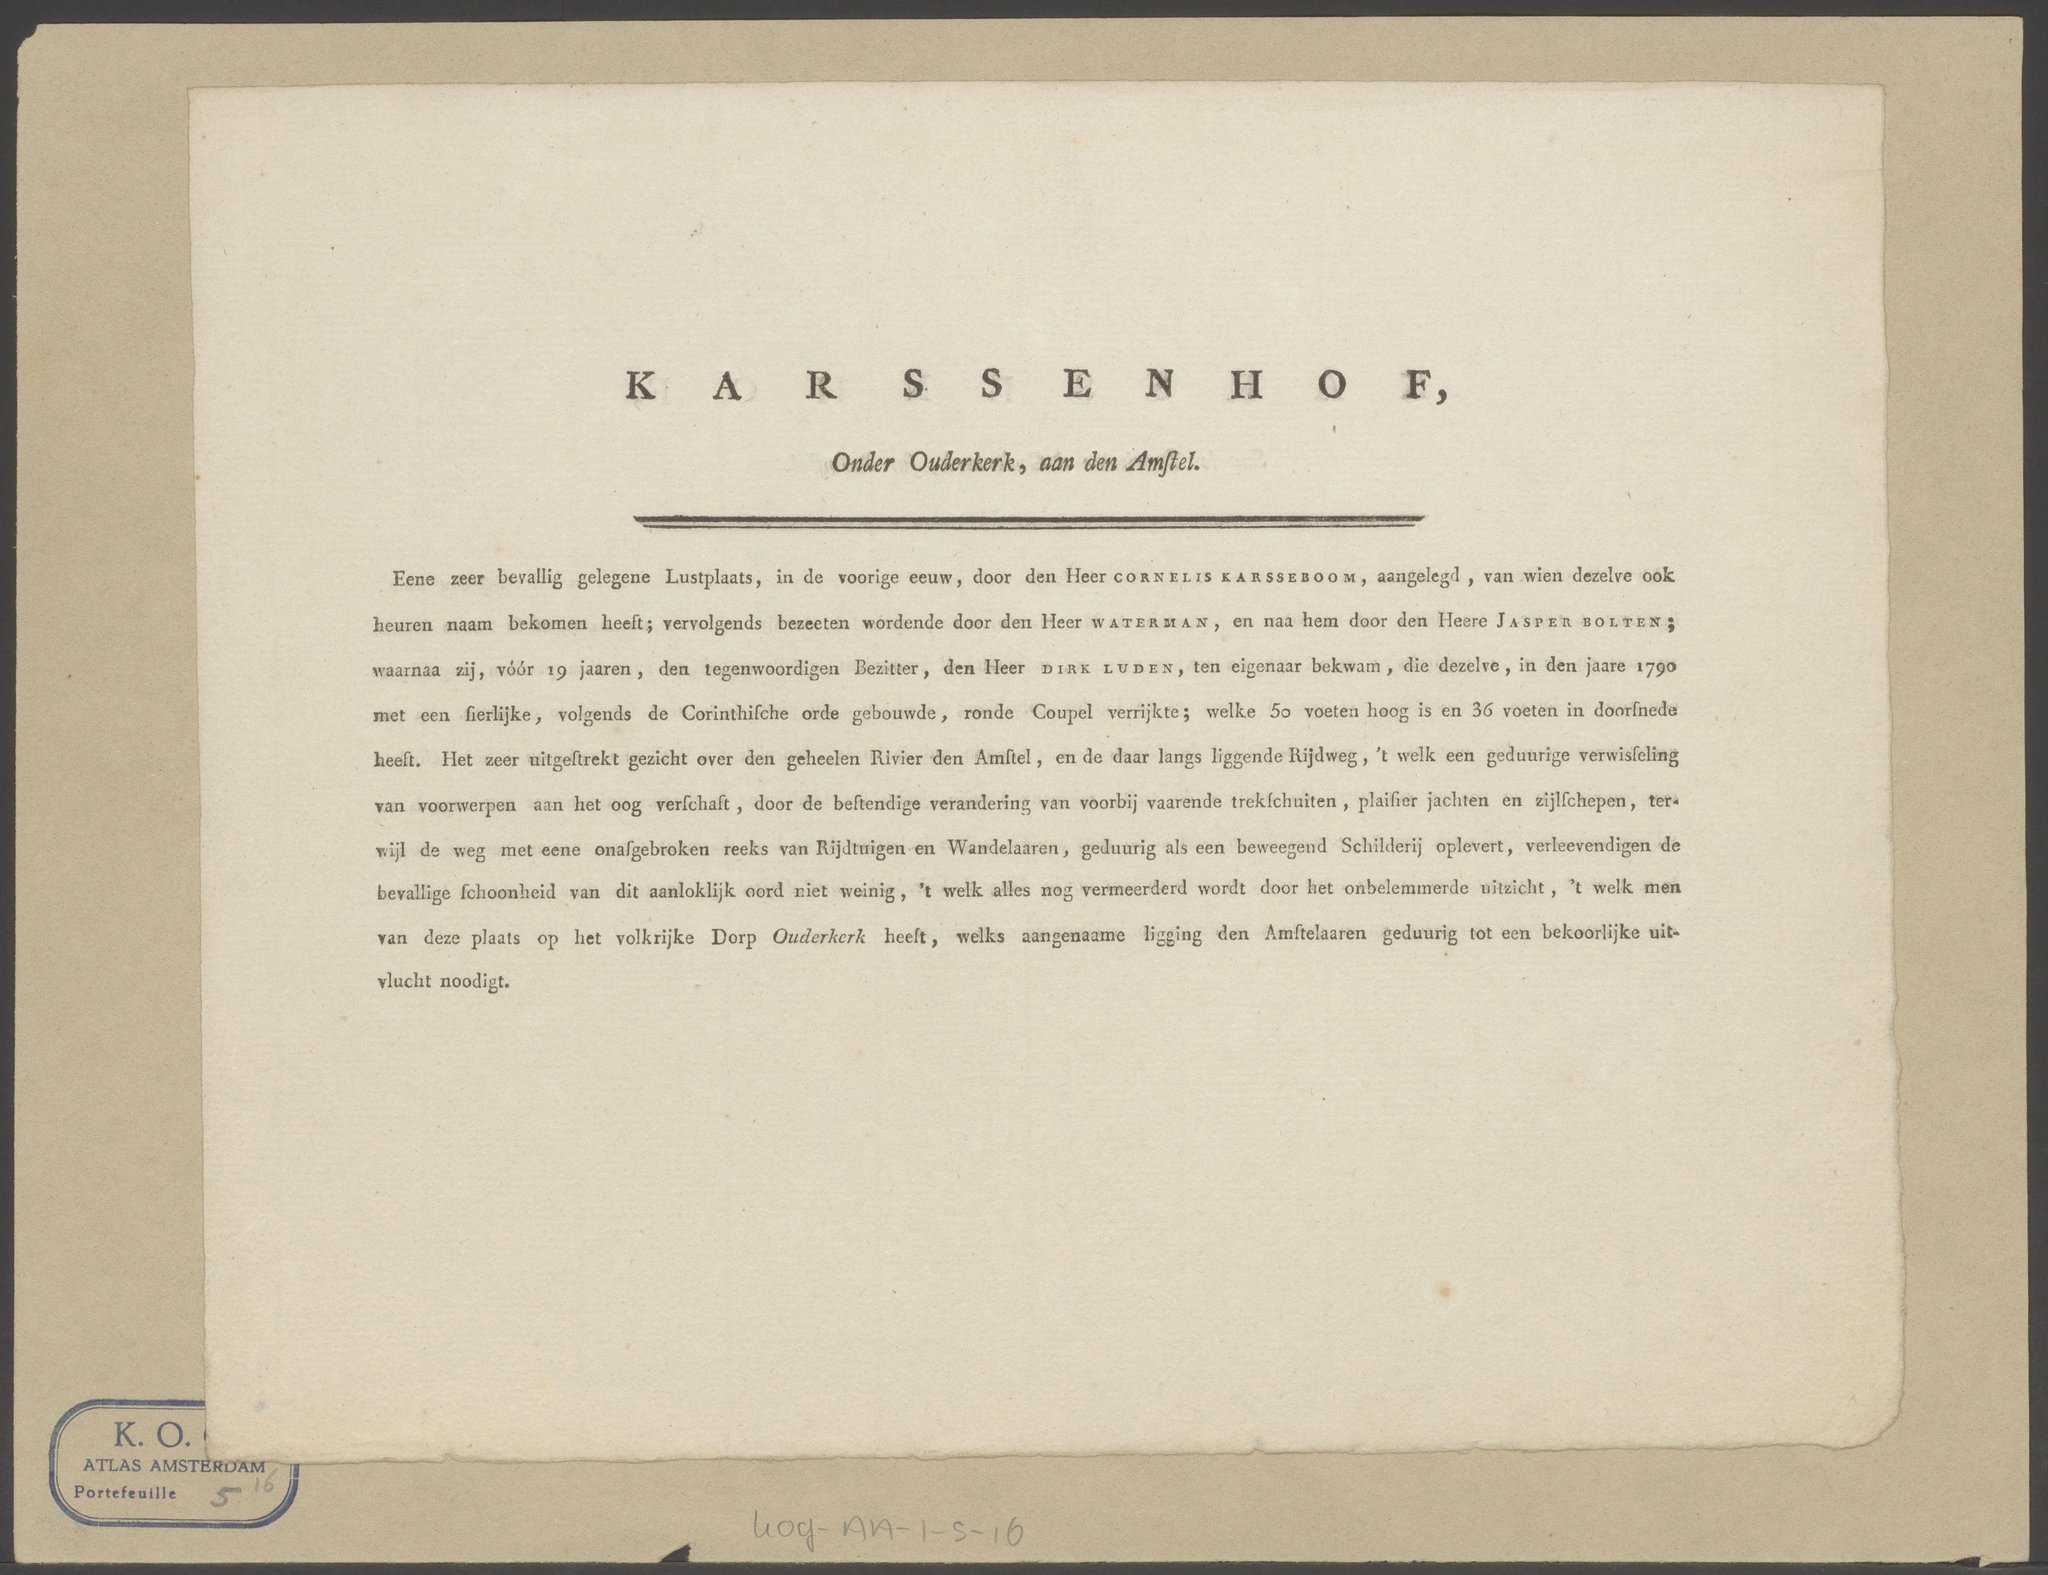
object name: text sheet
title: Beschrijving van buitenplaats Karssenhof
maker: hermanus numan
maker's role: draughtsman, painter, print maker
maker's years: 1744-1820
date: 1797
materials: paper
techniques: letterpress printing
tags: rural housing, e.g. country-house, villa, cottage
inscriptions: collector's mark: ‘5 16’ Lugt 1641b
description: Bladzijde uit: Numan, Hermanus. Vierentwintig printtekeningen met couleuren, verbeeldende Hollandsche buitenplaatzen, met derzelver beschrijvingen. Na het leven getekend en in plaat gebracht door H. Numan. Amsterdam: Hermanus Numan, 1797.